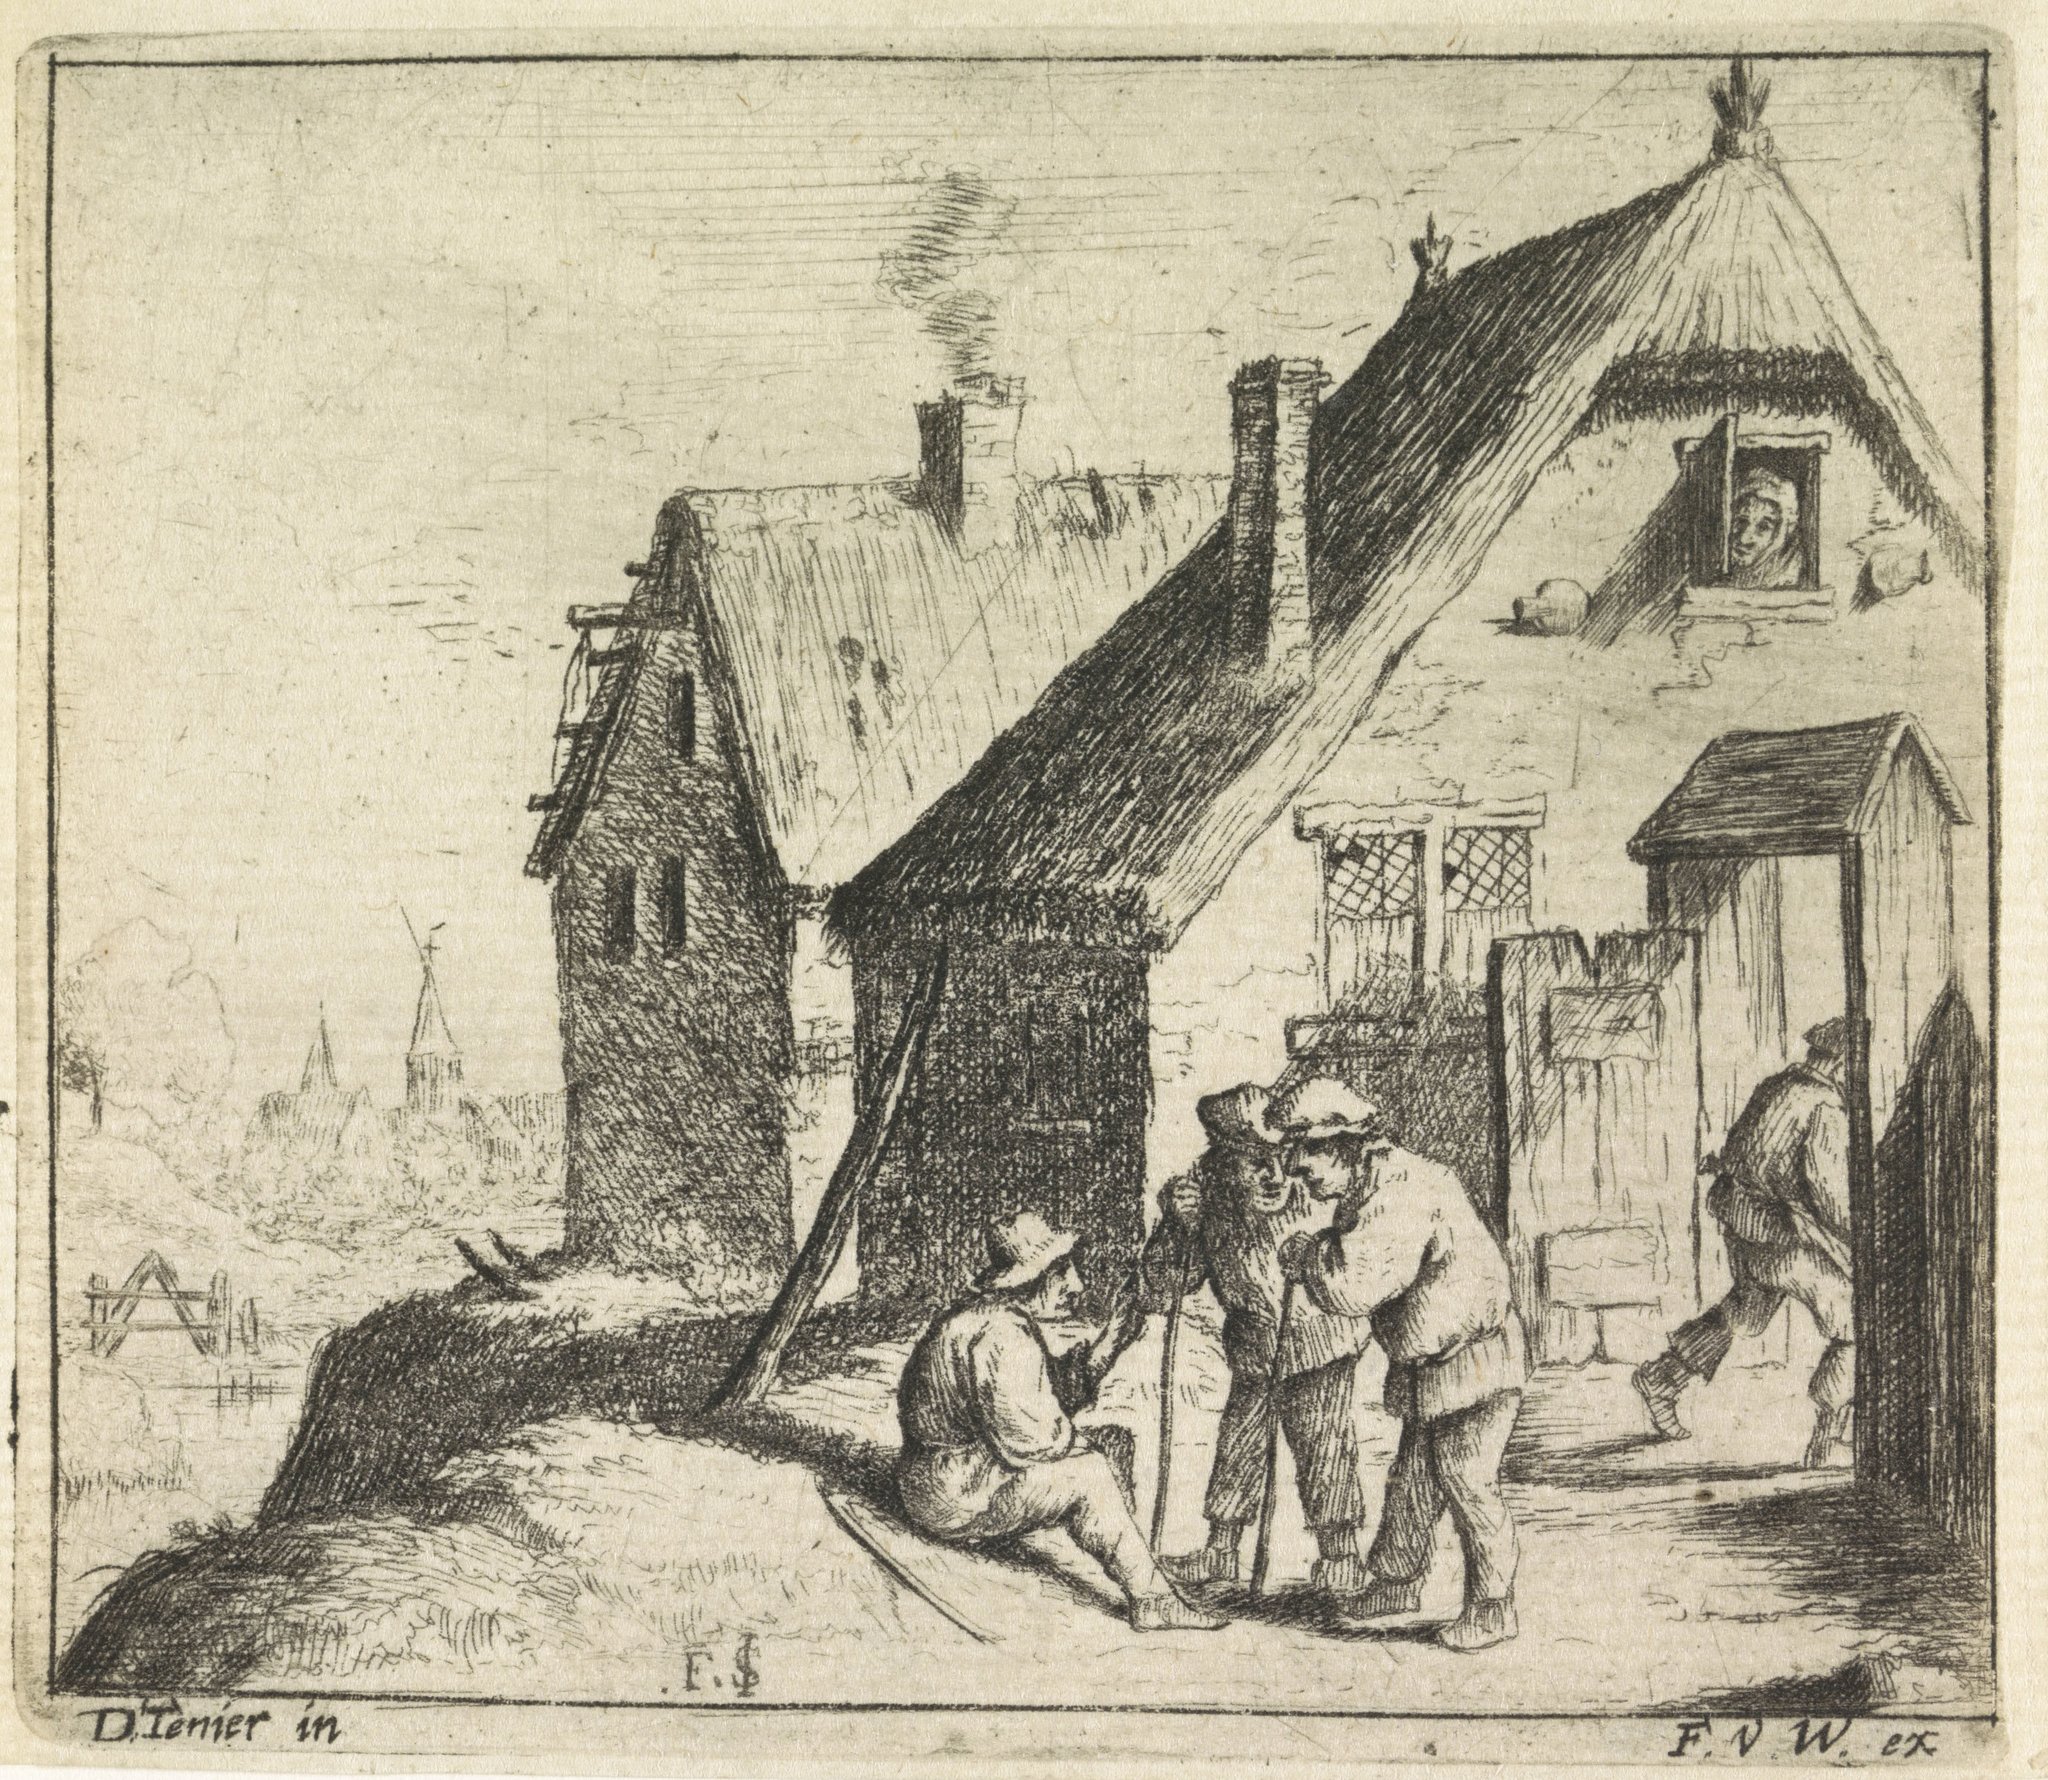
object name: print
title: Drie mannen in gesprek bij een woning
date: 1624-1679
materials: paper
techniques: etching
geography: antwerp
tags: walking-stick, staff, conversation, dialogue; conversation piece, farm (building)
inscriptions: collector's mark: Lugt 240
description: Drie mannen, waarvan twee met wandelstok, in gesprek bij een boerenwoning. Rechts stapt iemand door de poort van een hek.